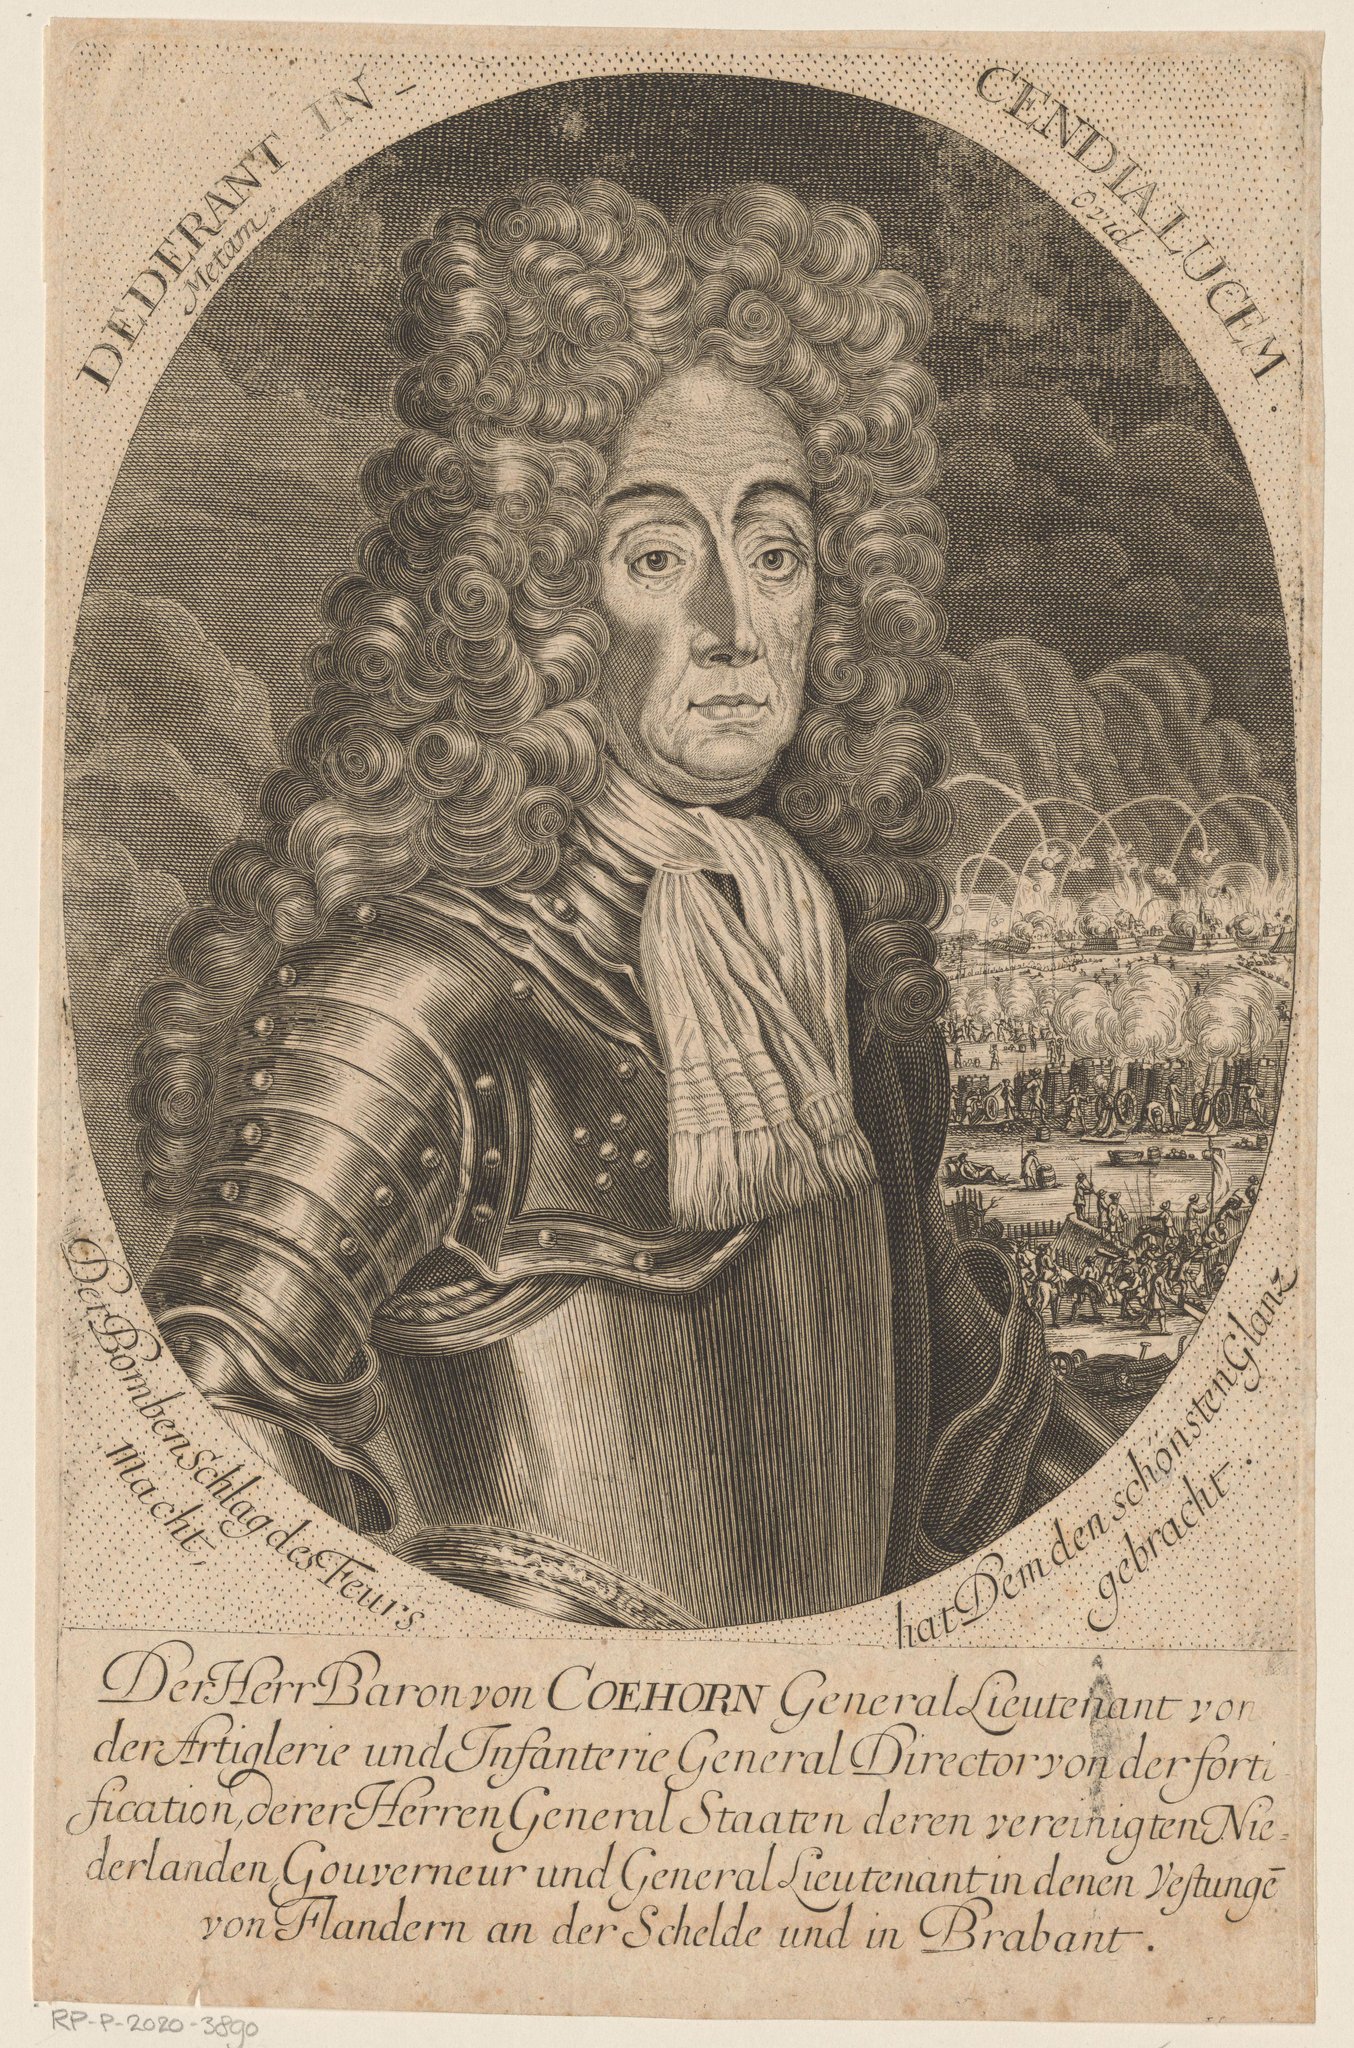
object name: print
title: Portret van Menno, baron van Coehoorn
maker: cornelis apeus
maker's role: print maker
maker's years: 1634-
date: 1665-1688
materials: paper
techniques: engraving, etching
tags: the hague, historical persons